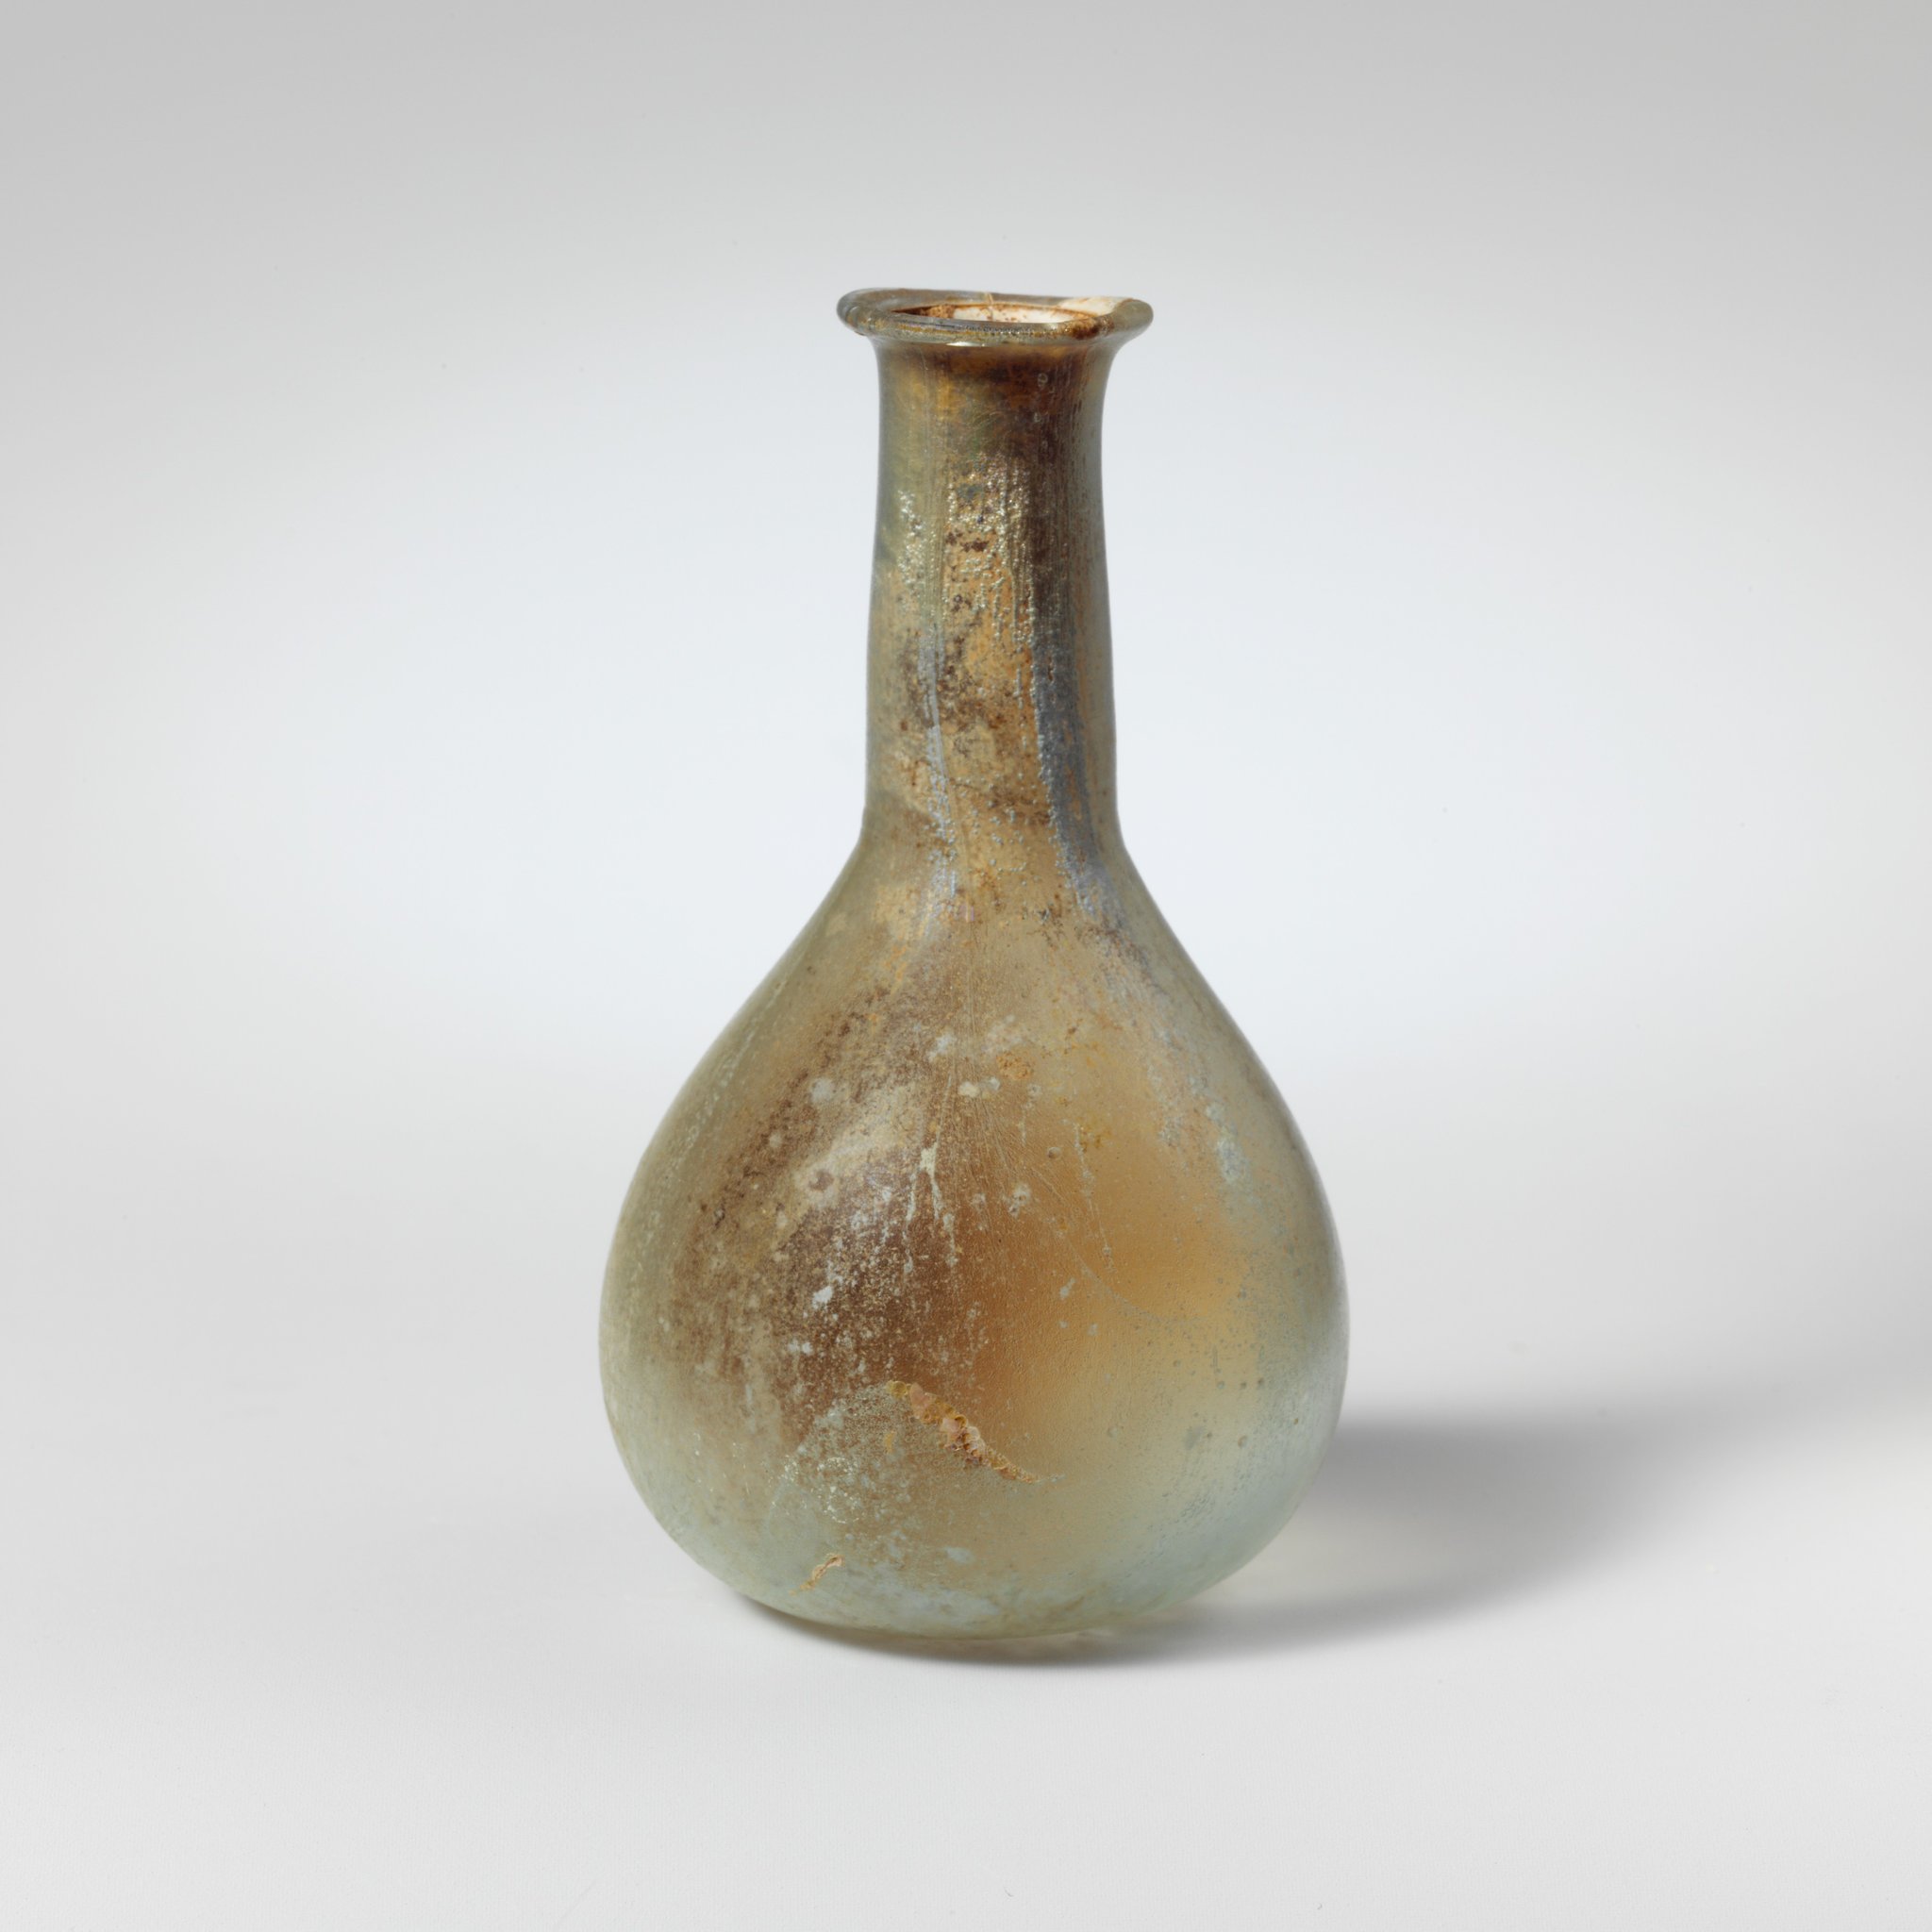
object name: perfume bottle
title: Glass perfume bottle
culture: roman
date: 1-100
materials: glass